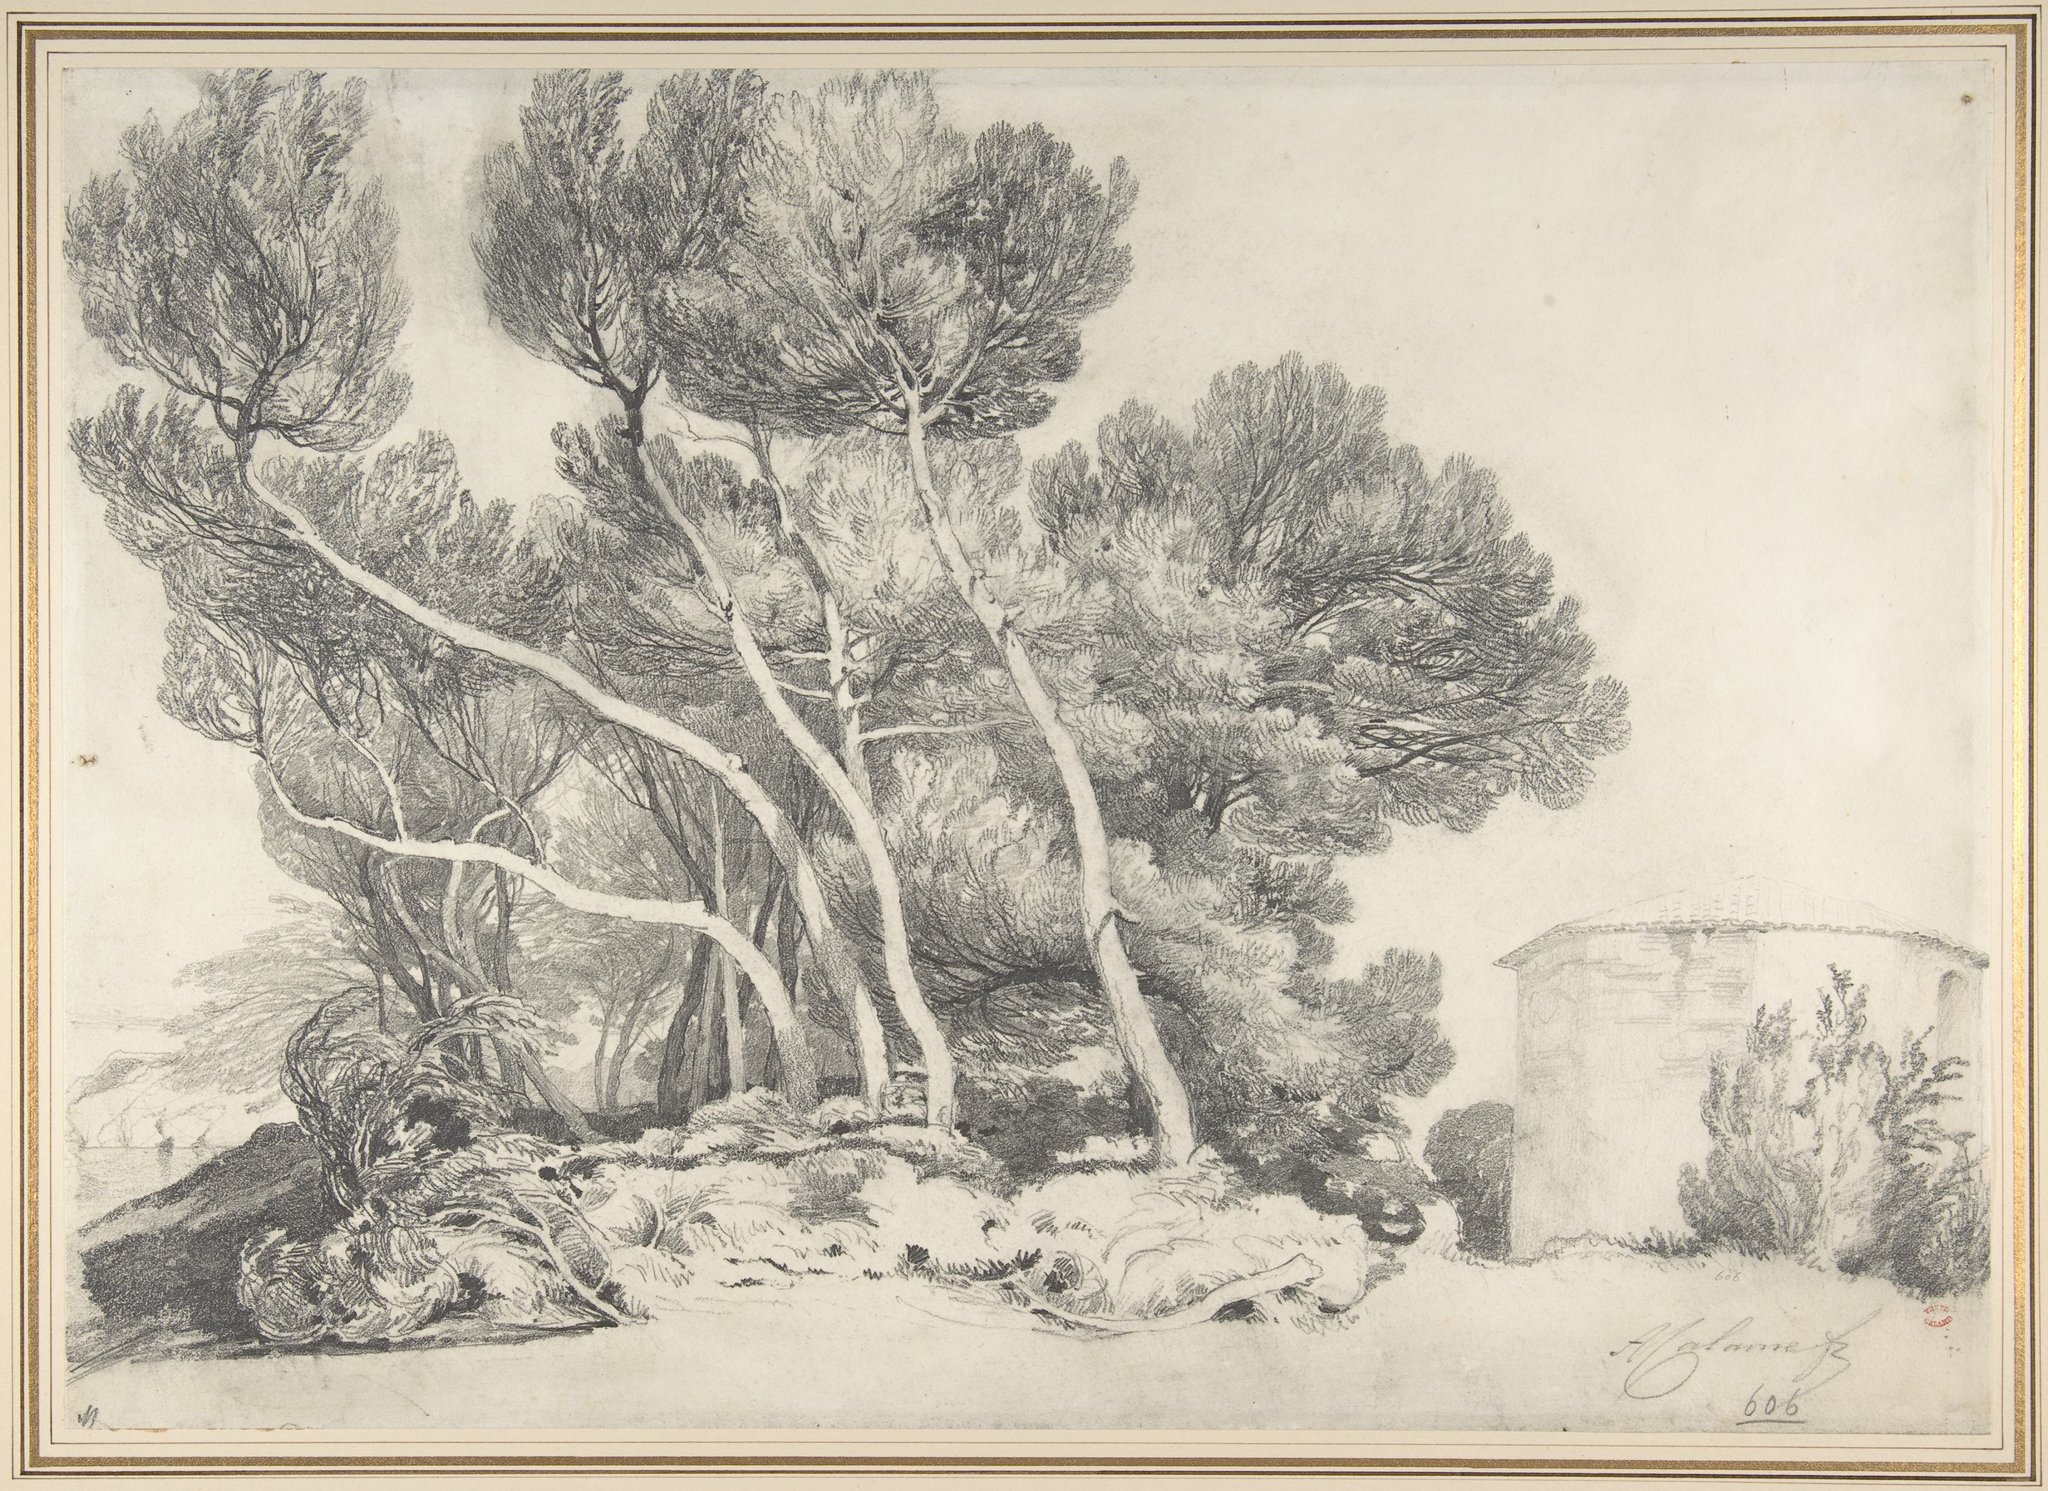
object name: drawing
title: Landscape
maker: alexandre calame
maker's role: artist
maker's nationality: swiss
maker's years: 1810-1864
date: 1825-1864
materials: graphite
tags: landscapes,trees